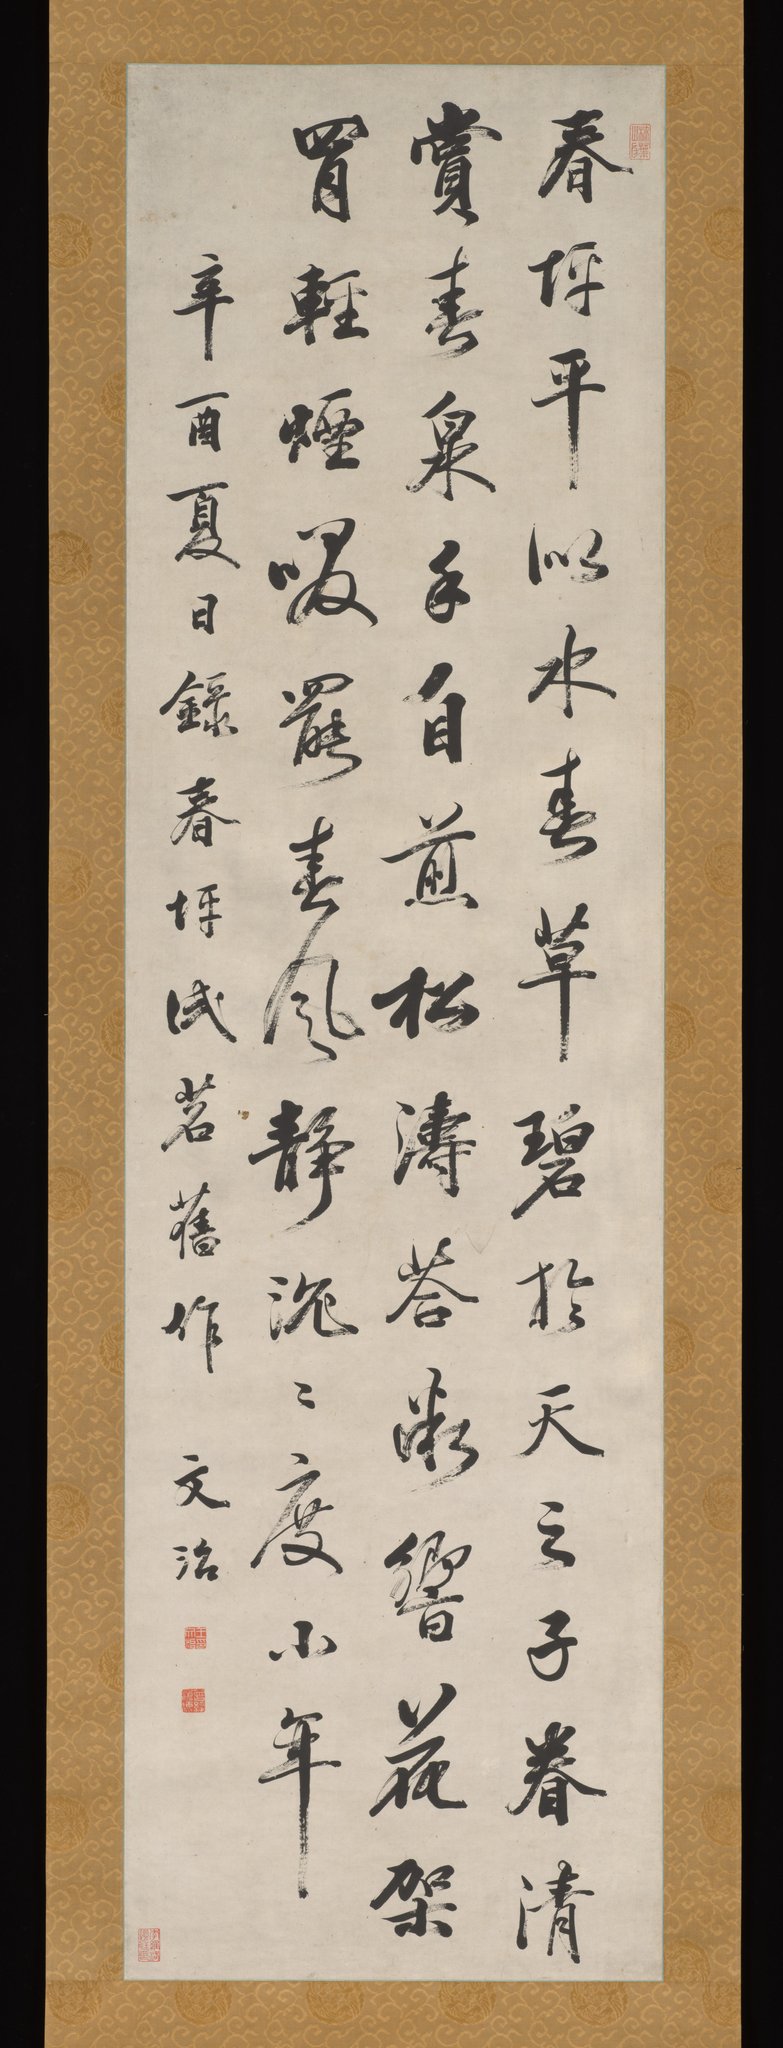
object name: hanging scroll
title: Calligraphy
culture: chinese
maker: wang wenzhi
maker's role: artist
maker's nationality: chinese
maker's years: 1730-1802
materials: ink, paper